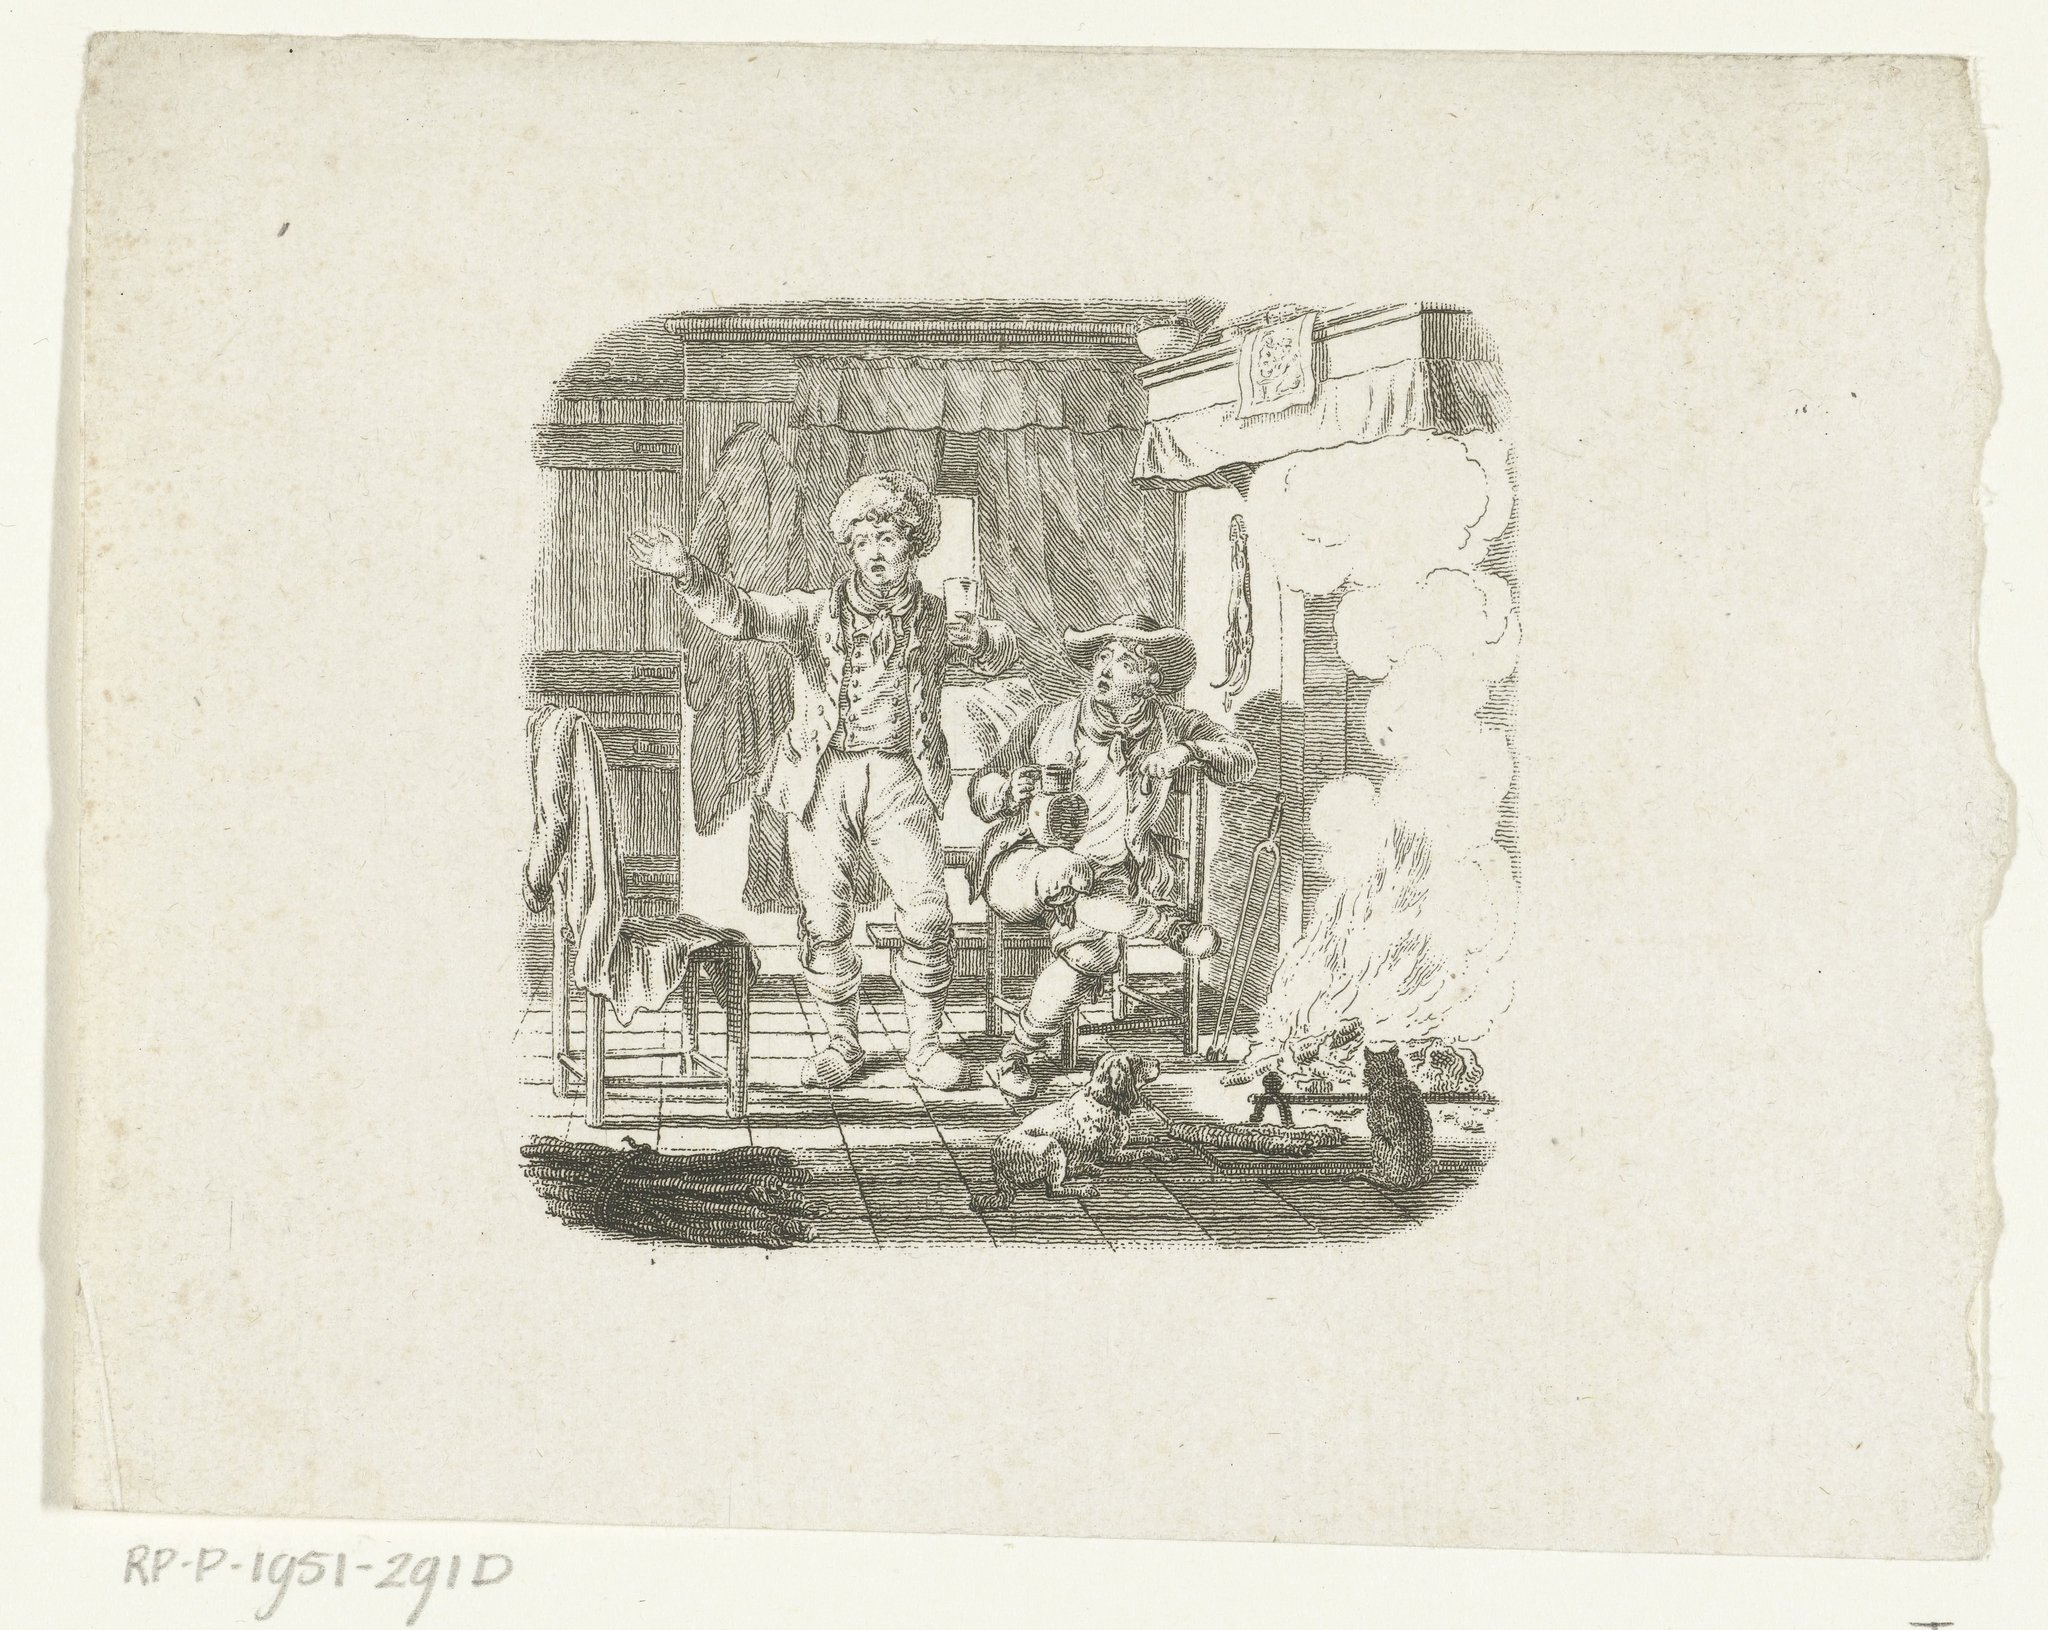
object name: print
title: Twee mannen in gesprek bij haardvuur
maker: johannes christiaan bendorp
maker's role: print maker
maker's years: 1766-1849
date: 1776-1849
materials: paper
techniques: etching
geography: netherlands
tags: loose company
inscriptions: collector's mark: Lugt 2228